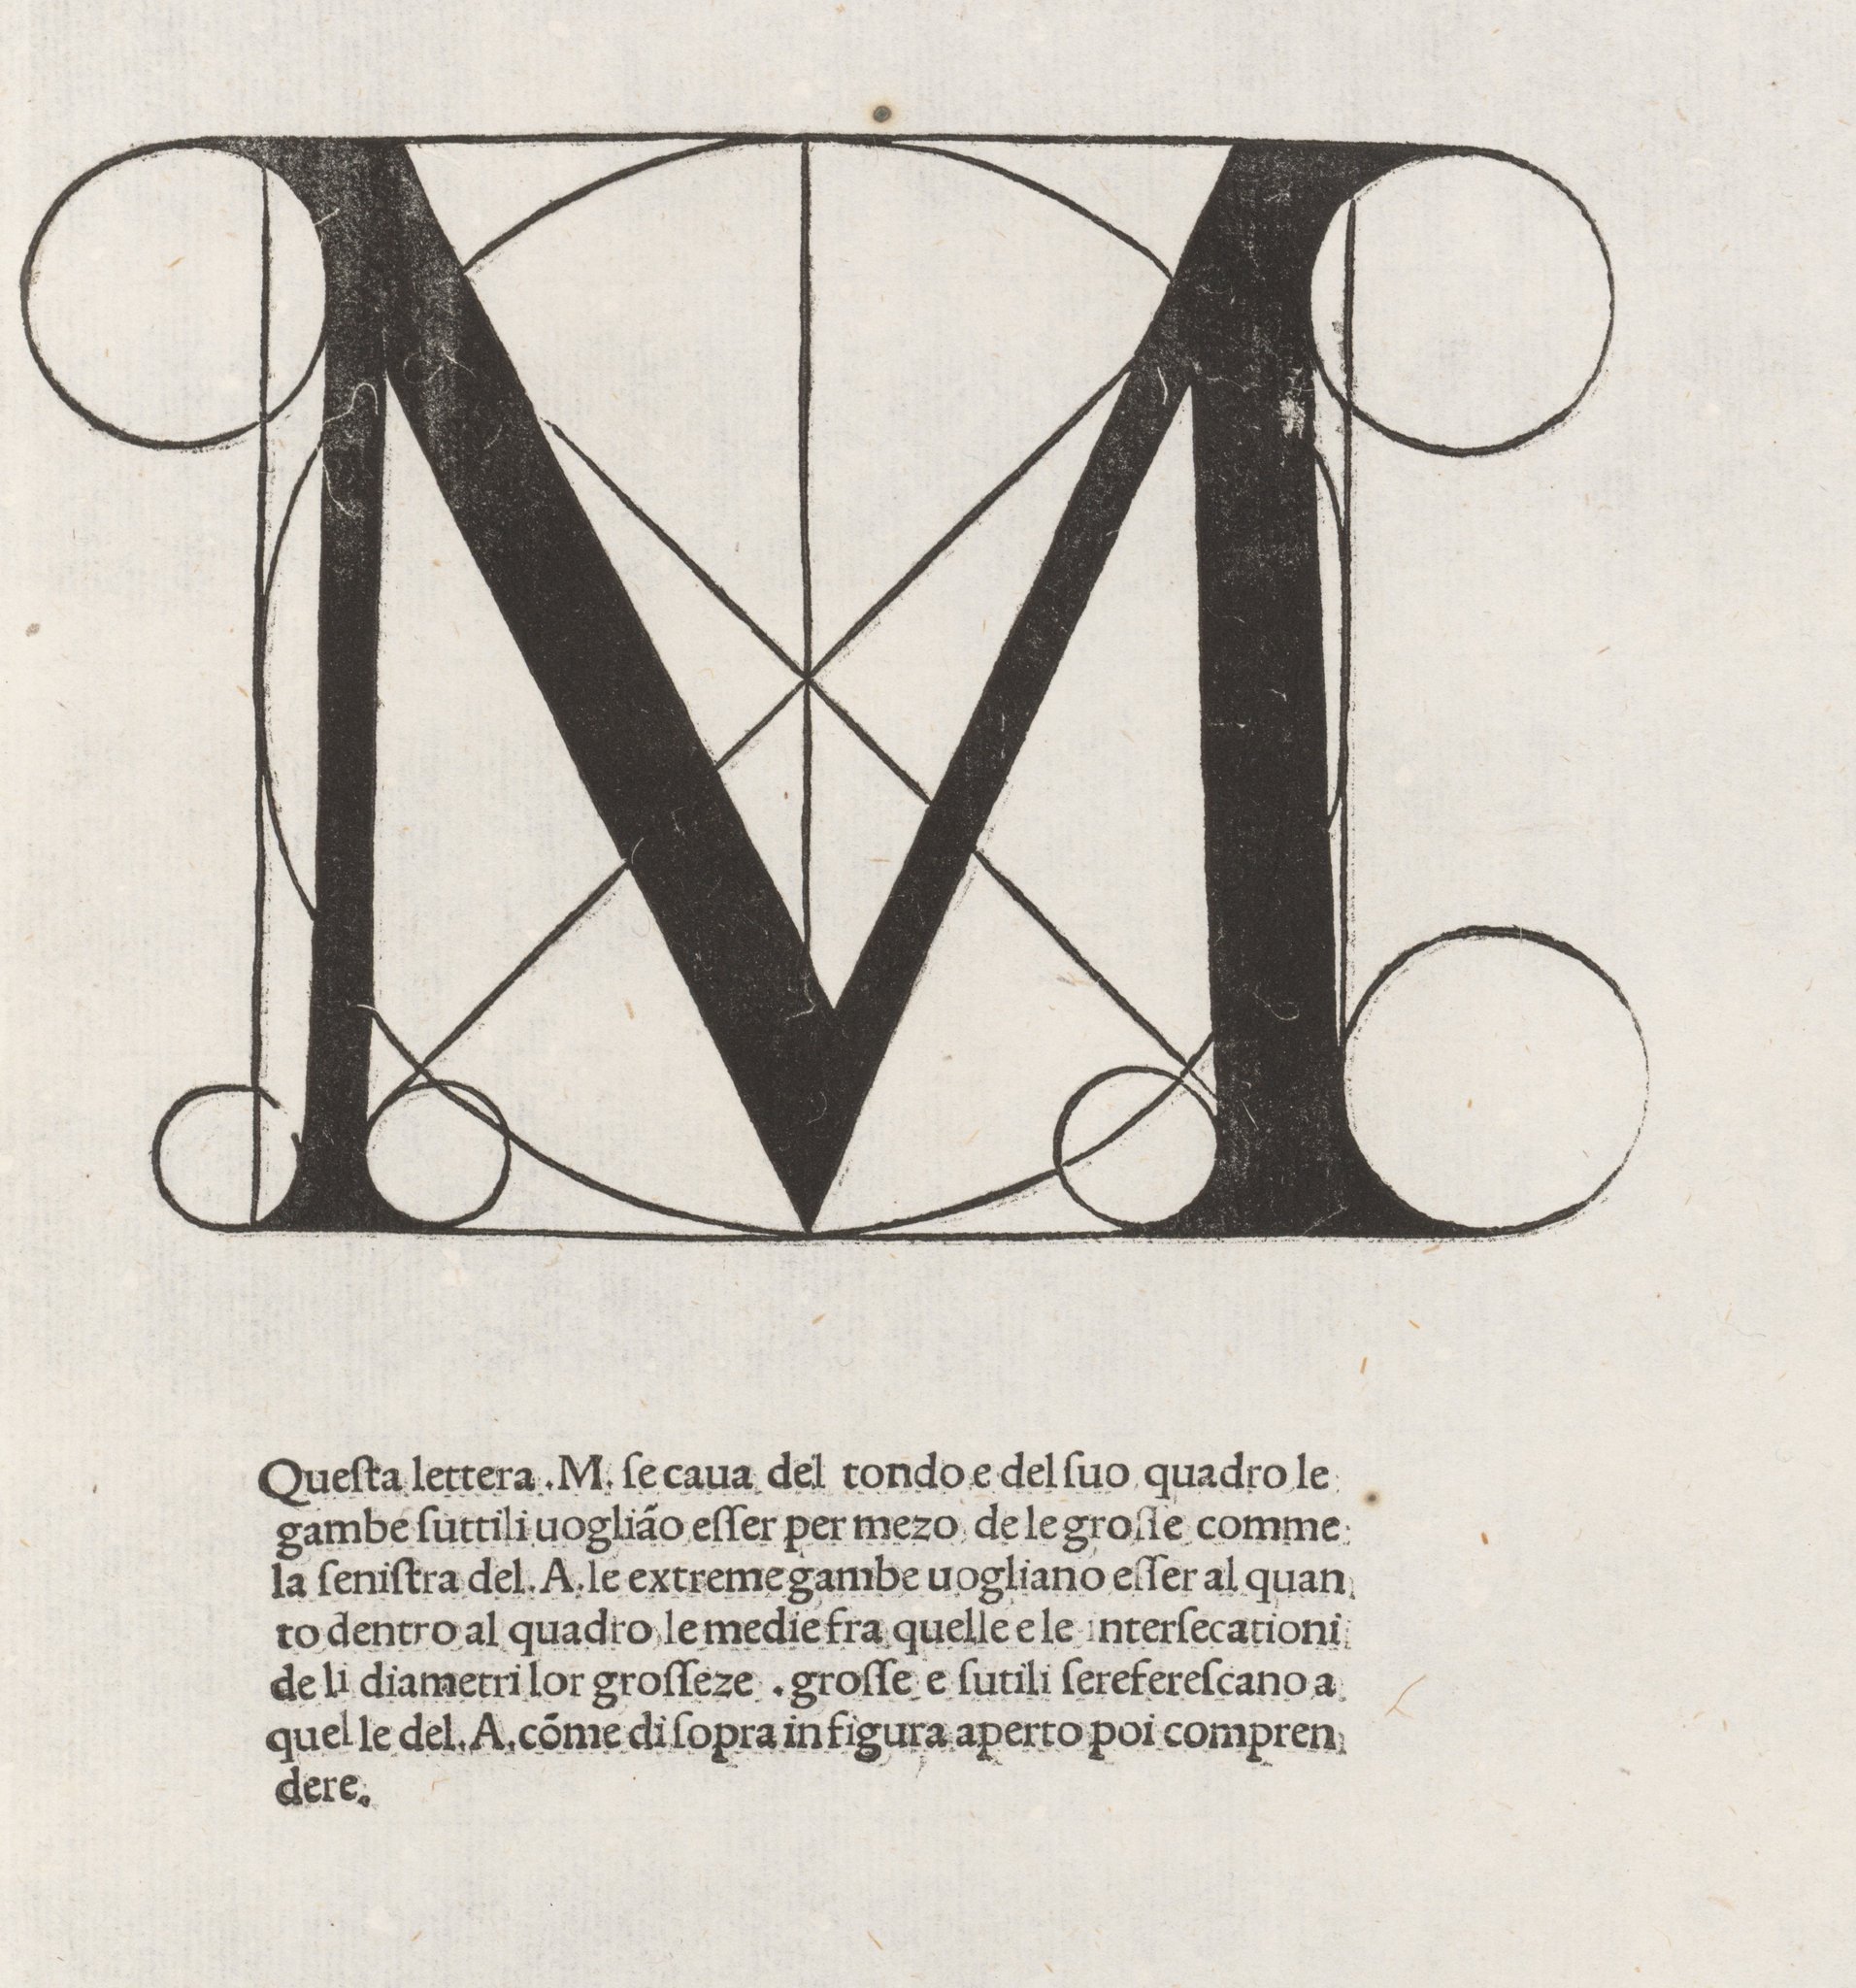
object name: book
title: Divina proportione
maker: leonardo da vinci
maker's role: designer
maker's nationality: italian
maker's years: 1452-1519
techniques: woodcut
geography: italy